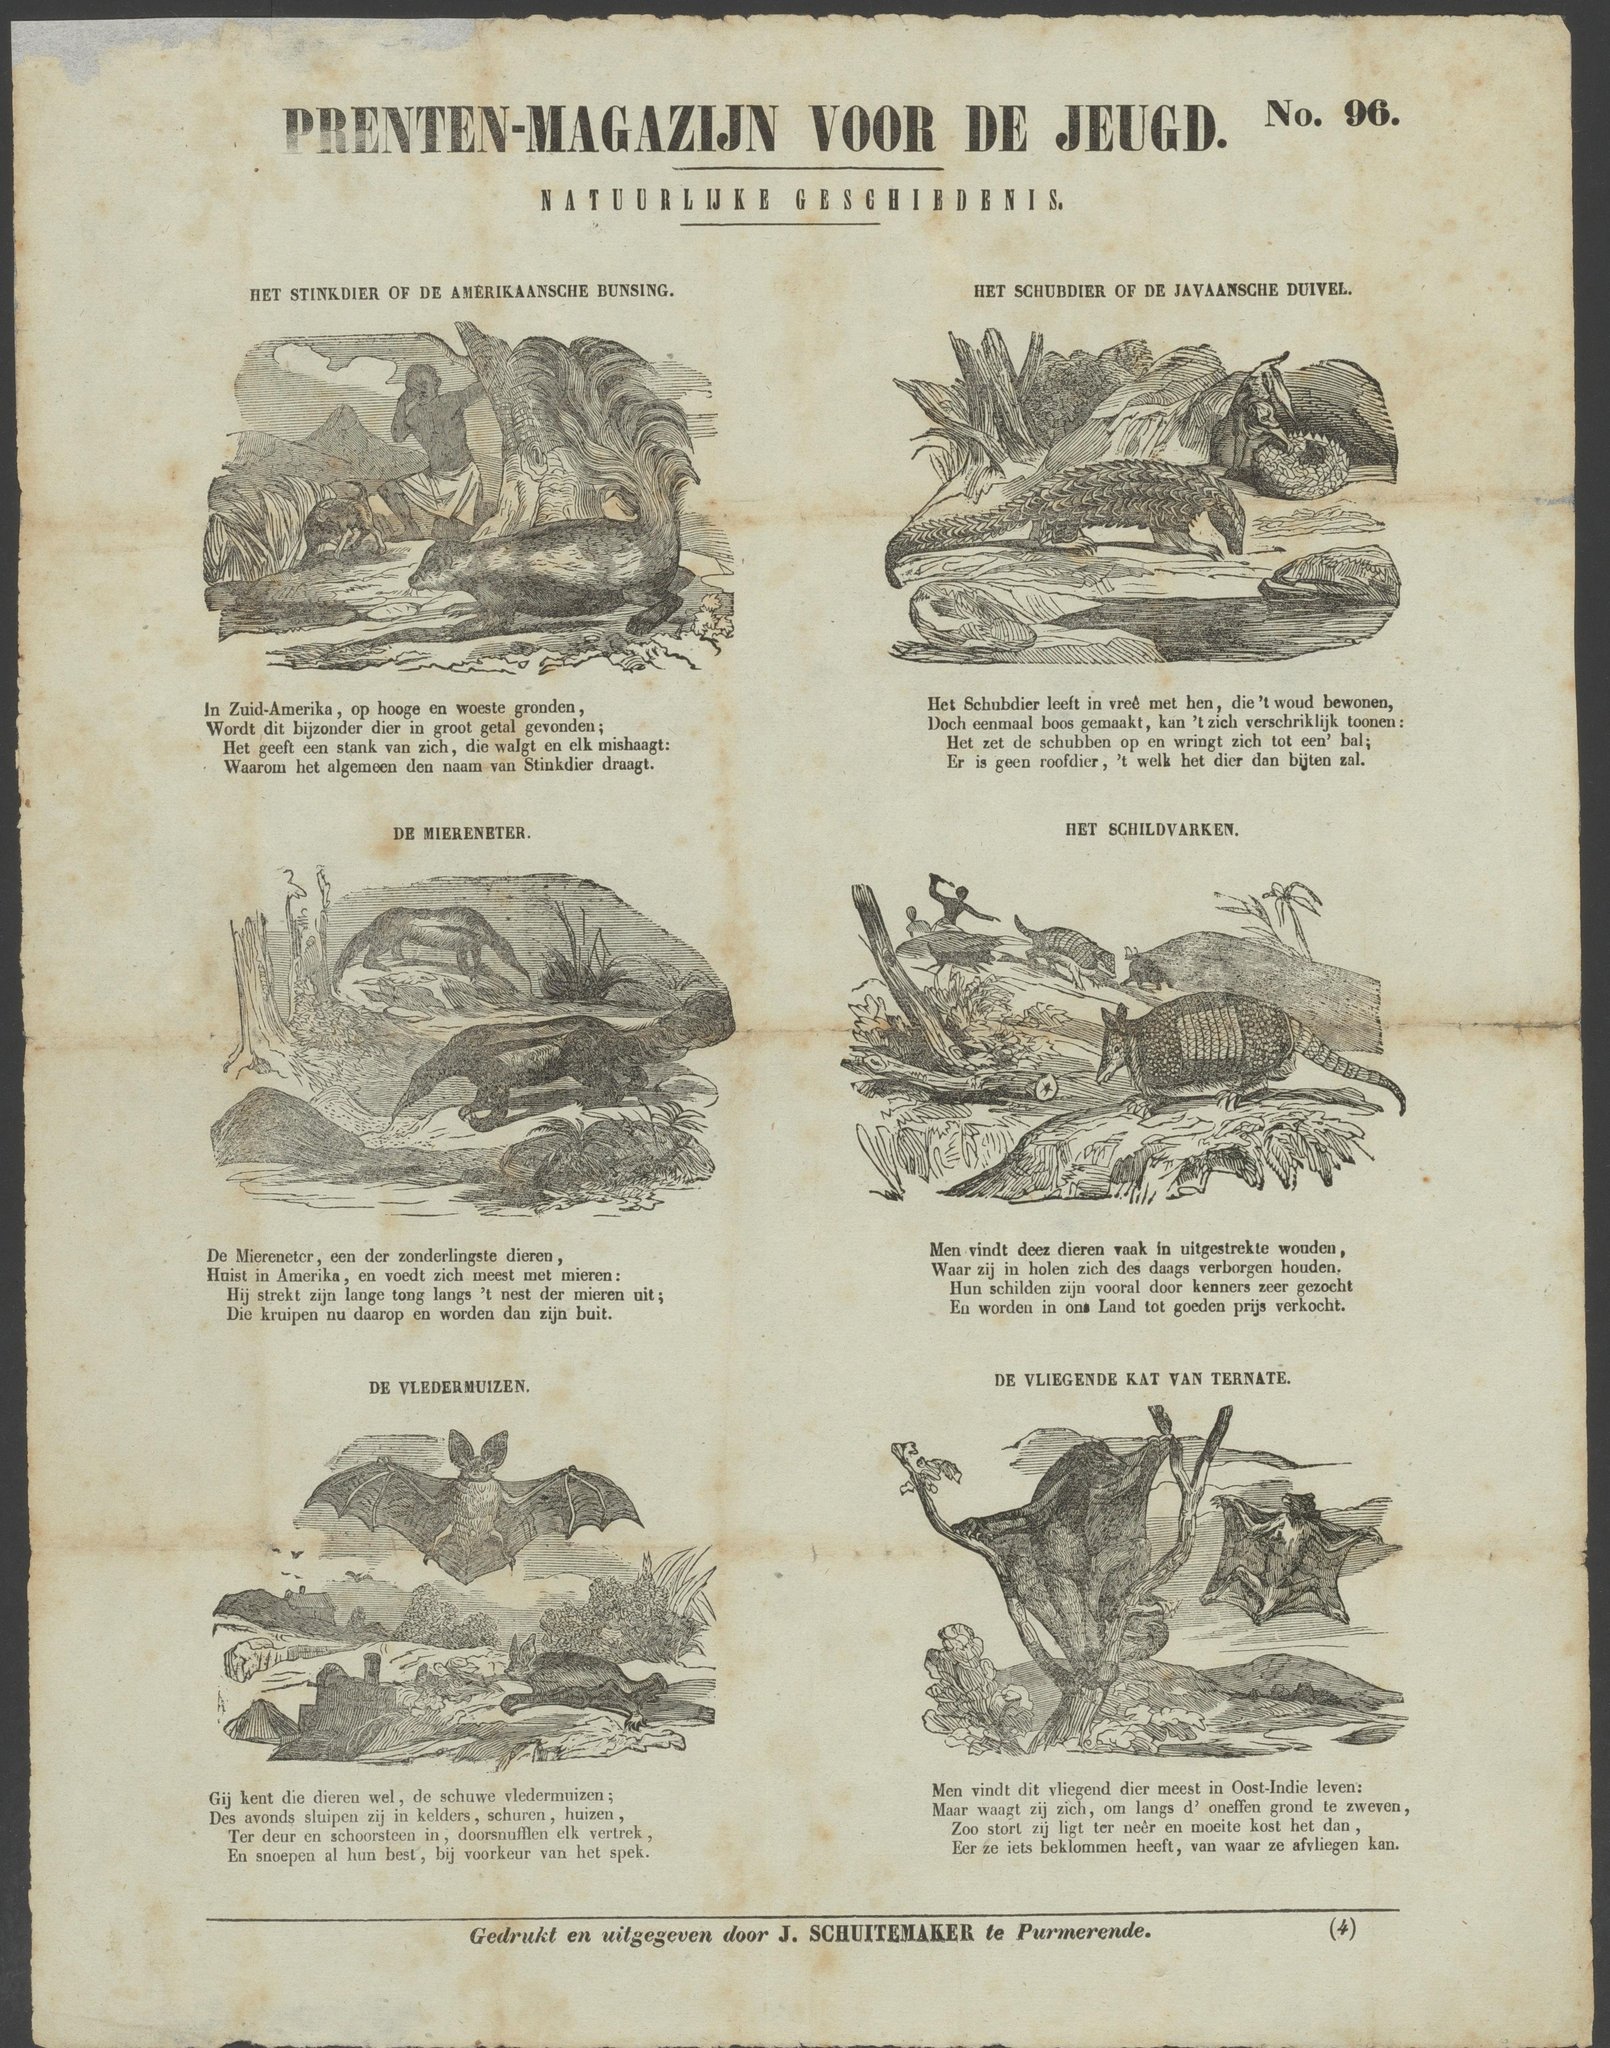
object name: print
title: Prenten-magazijn voor de jeugd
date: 1850-1858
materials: paper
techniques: letterpress printing, engraving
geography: purmerend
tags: flying mammals: bat, animals, other mammals: armadillo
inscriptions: inscription: ‘Van H. Nikolaas voor Agatha Hilhorst 1858’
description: Blad met zes voorstellingen van verschillende dieren, zoals een stinkdier, een miereneter en een vleermuis. Boven elke voorstelling een titel en onder elke voorstelling een vierregelig vers. Genummerd rechtsboven: No. 96, genummerd rechtsonder: (4.). Onderwerpsrubrieken binnen de Atlas Zeden en Gewoonten: Zeden en Gewoonten in Engeren Zin, Des menschen beging, midden en einde, Kinderleven – Kinderspel en Kinderprenten.